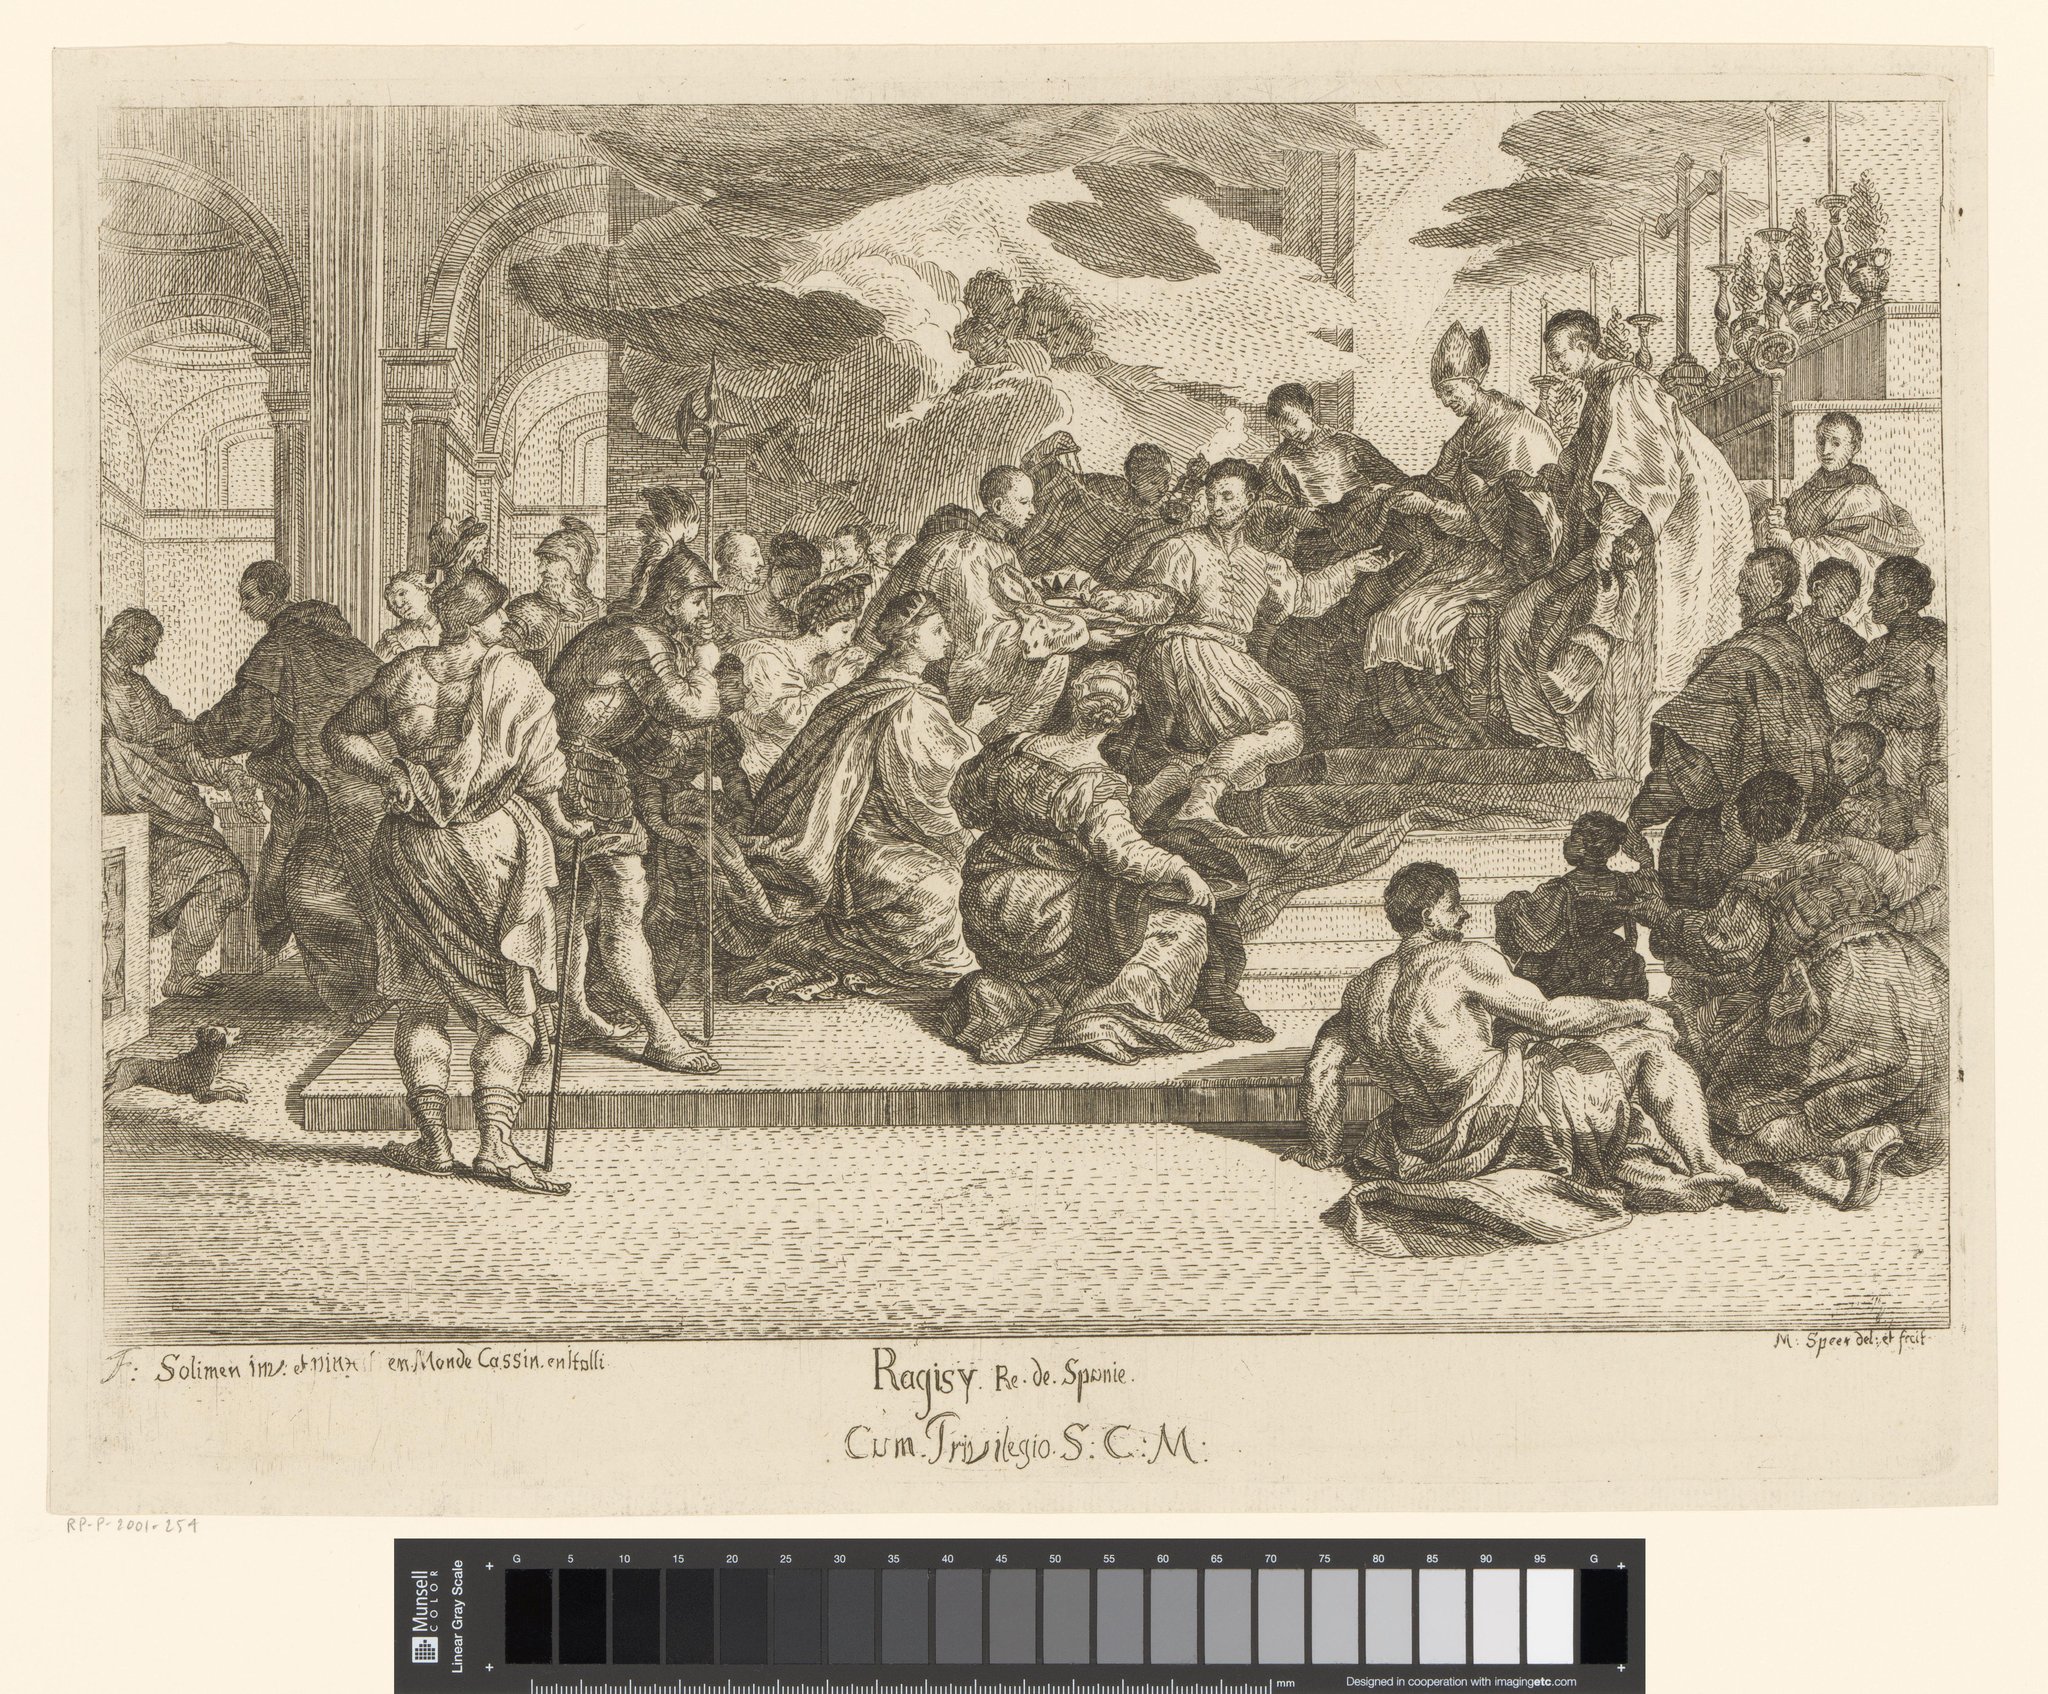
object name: print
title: Getroonde Spaanse bisschop met een groep geknielde figuren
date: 1722-1765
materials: paper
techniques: etching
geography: regensburg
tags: archbishop, bishop, etc. (roman catholic), kneeling before a ruler, bishop's throne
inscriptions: collector's mark: Lugt 2228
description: Prent naar een vernietigde schildering in de Abdij van Monte Cassino.